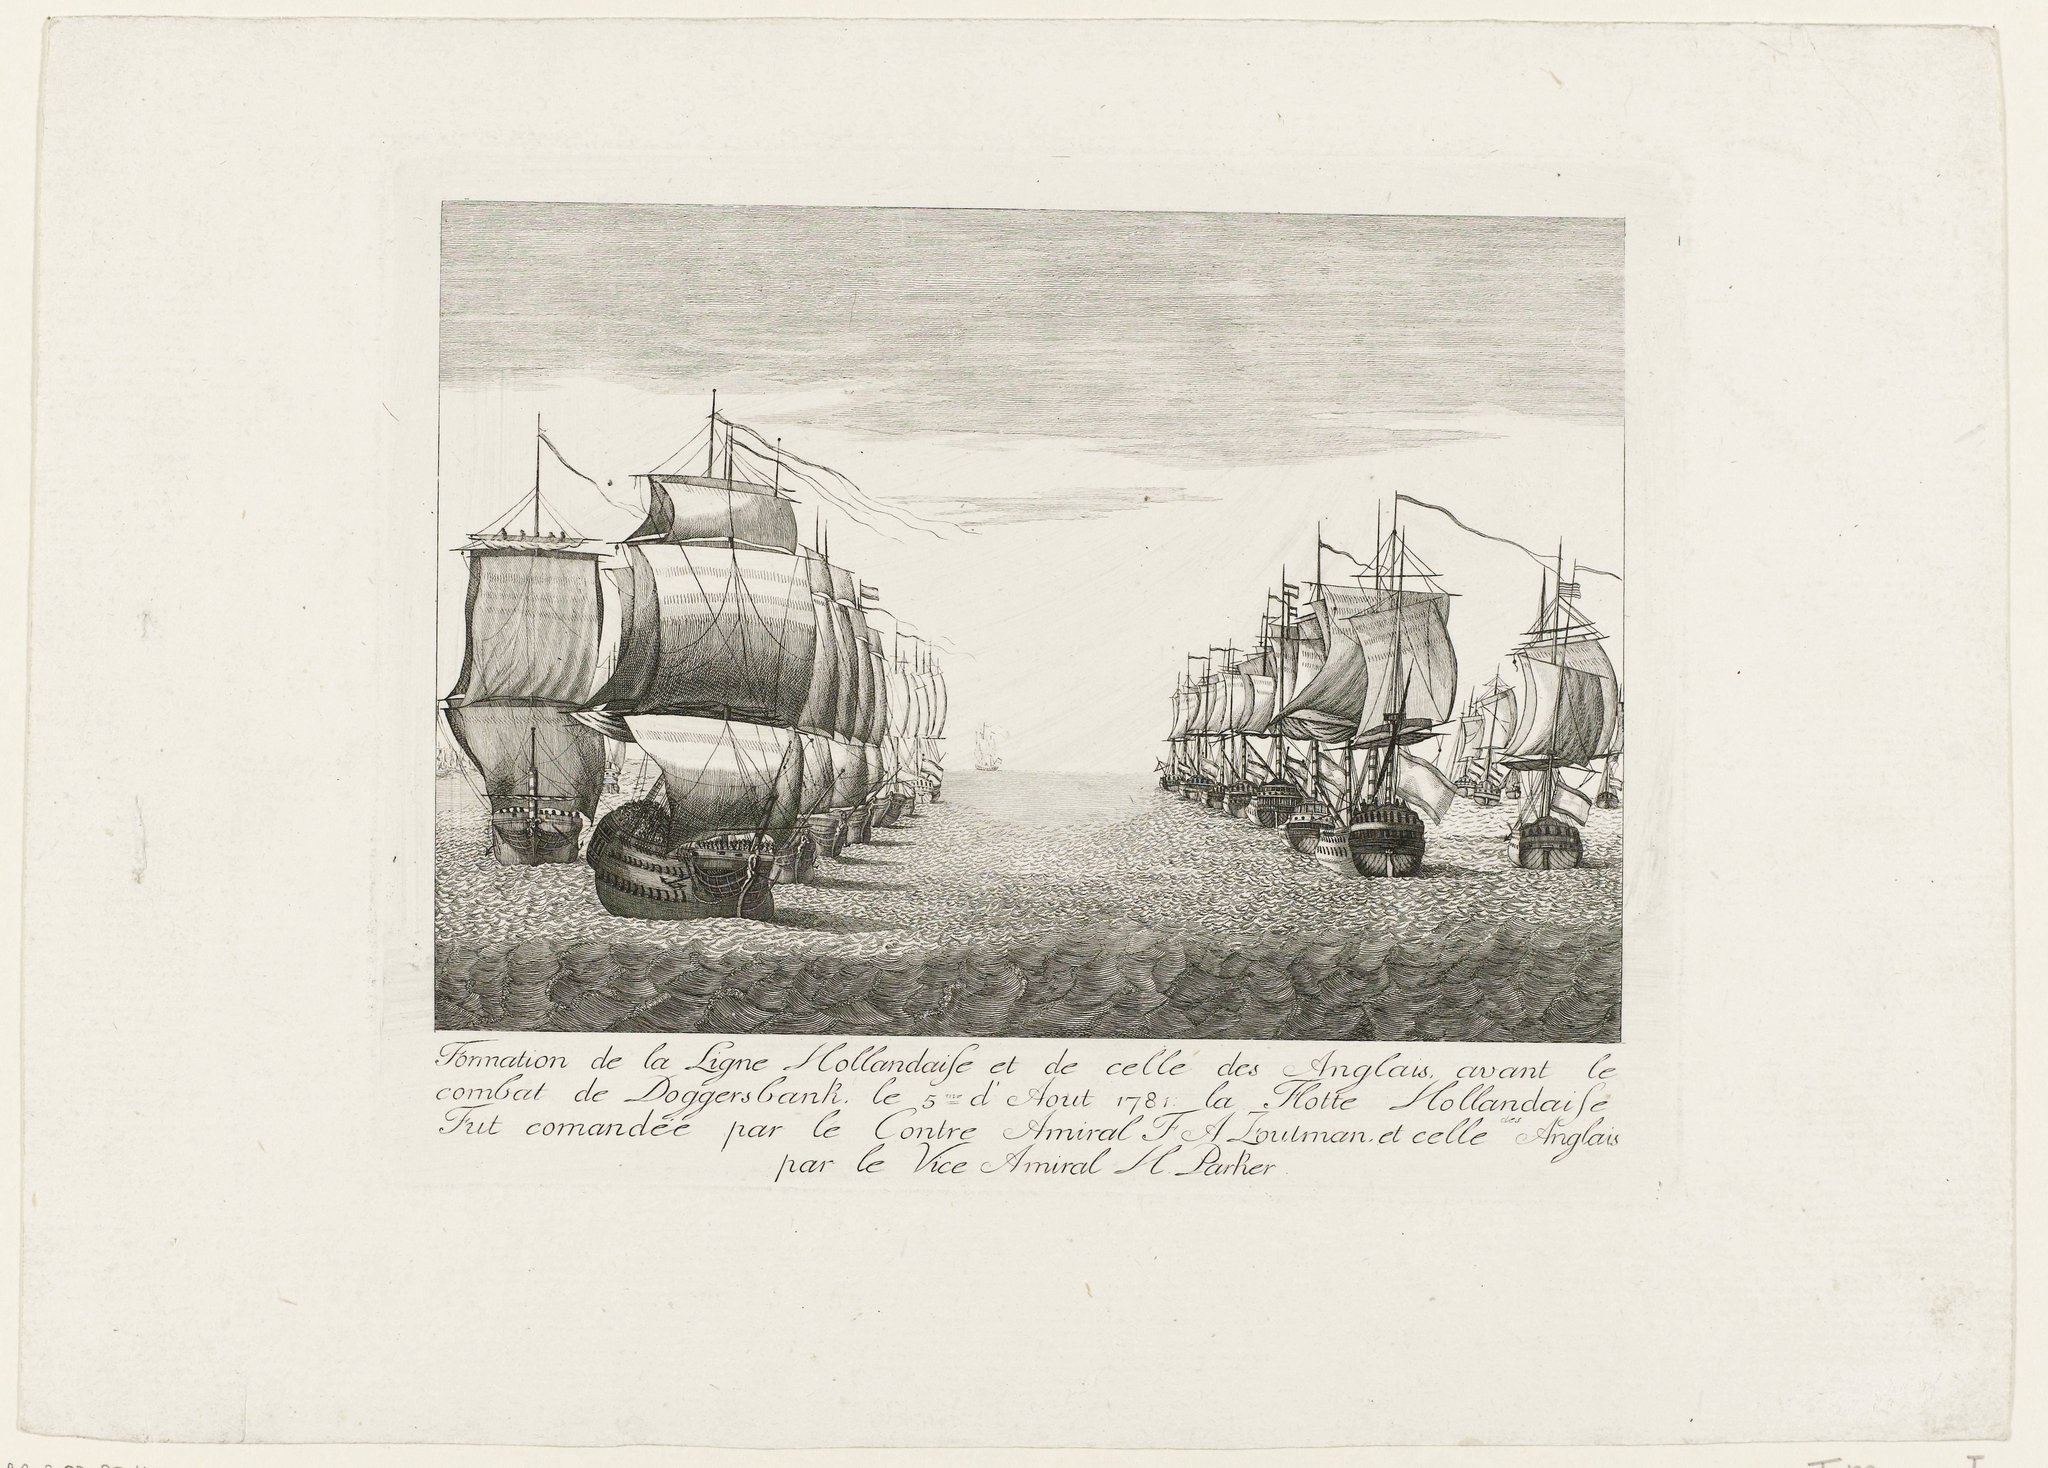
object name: print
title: Vier platen van zeeslagen in 1781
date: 1782-1790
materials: paper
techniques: engraving, etching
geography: rotterdam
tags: the hague, johan arnold zoutman, hyde parker, battle (+ naval force)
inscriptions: collector's mark: Lugt 2228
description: De Nederlandse en Engelse schepen in linie bij de aanvang van de zeeslag bij Doggersbank op 5 augustus 1781 tussen de Nederlandse vloot onder schout-bij-nacht Johan Zoutman en de Engelse vloot onder vice-admiraal Hyde Parker. In de marge de titel in het Frans. Onderdeel van een serie van vier platen van zeeslagen in het jaar 1781.